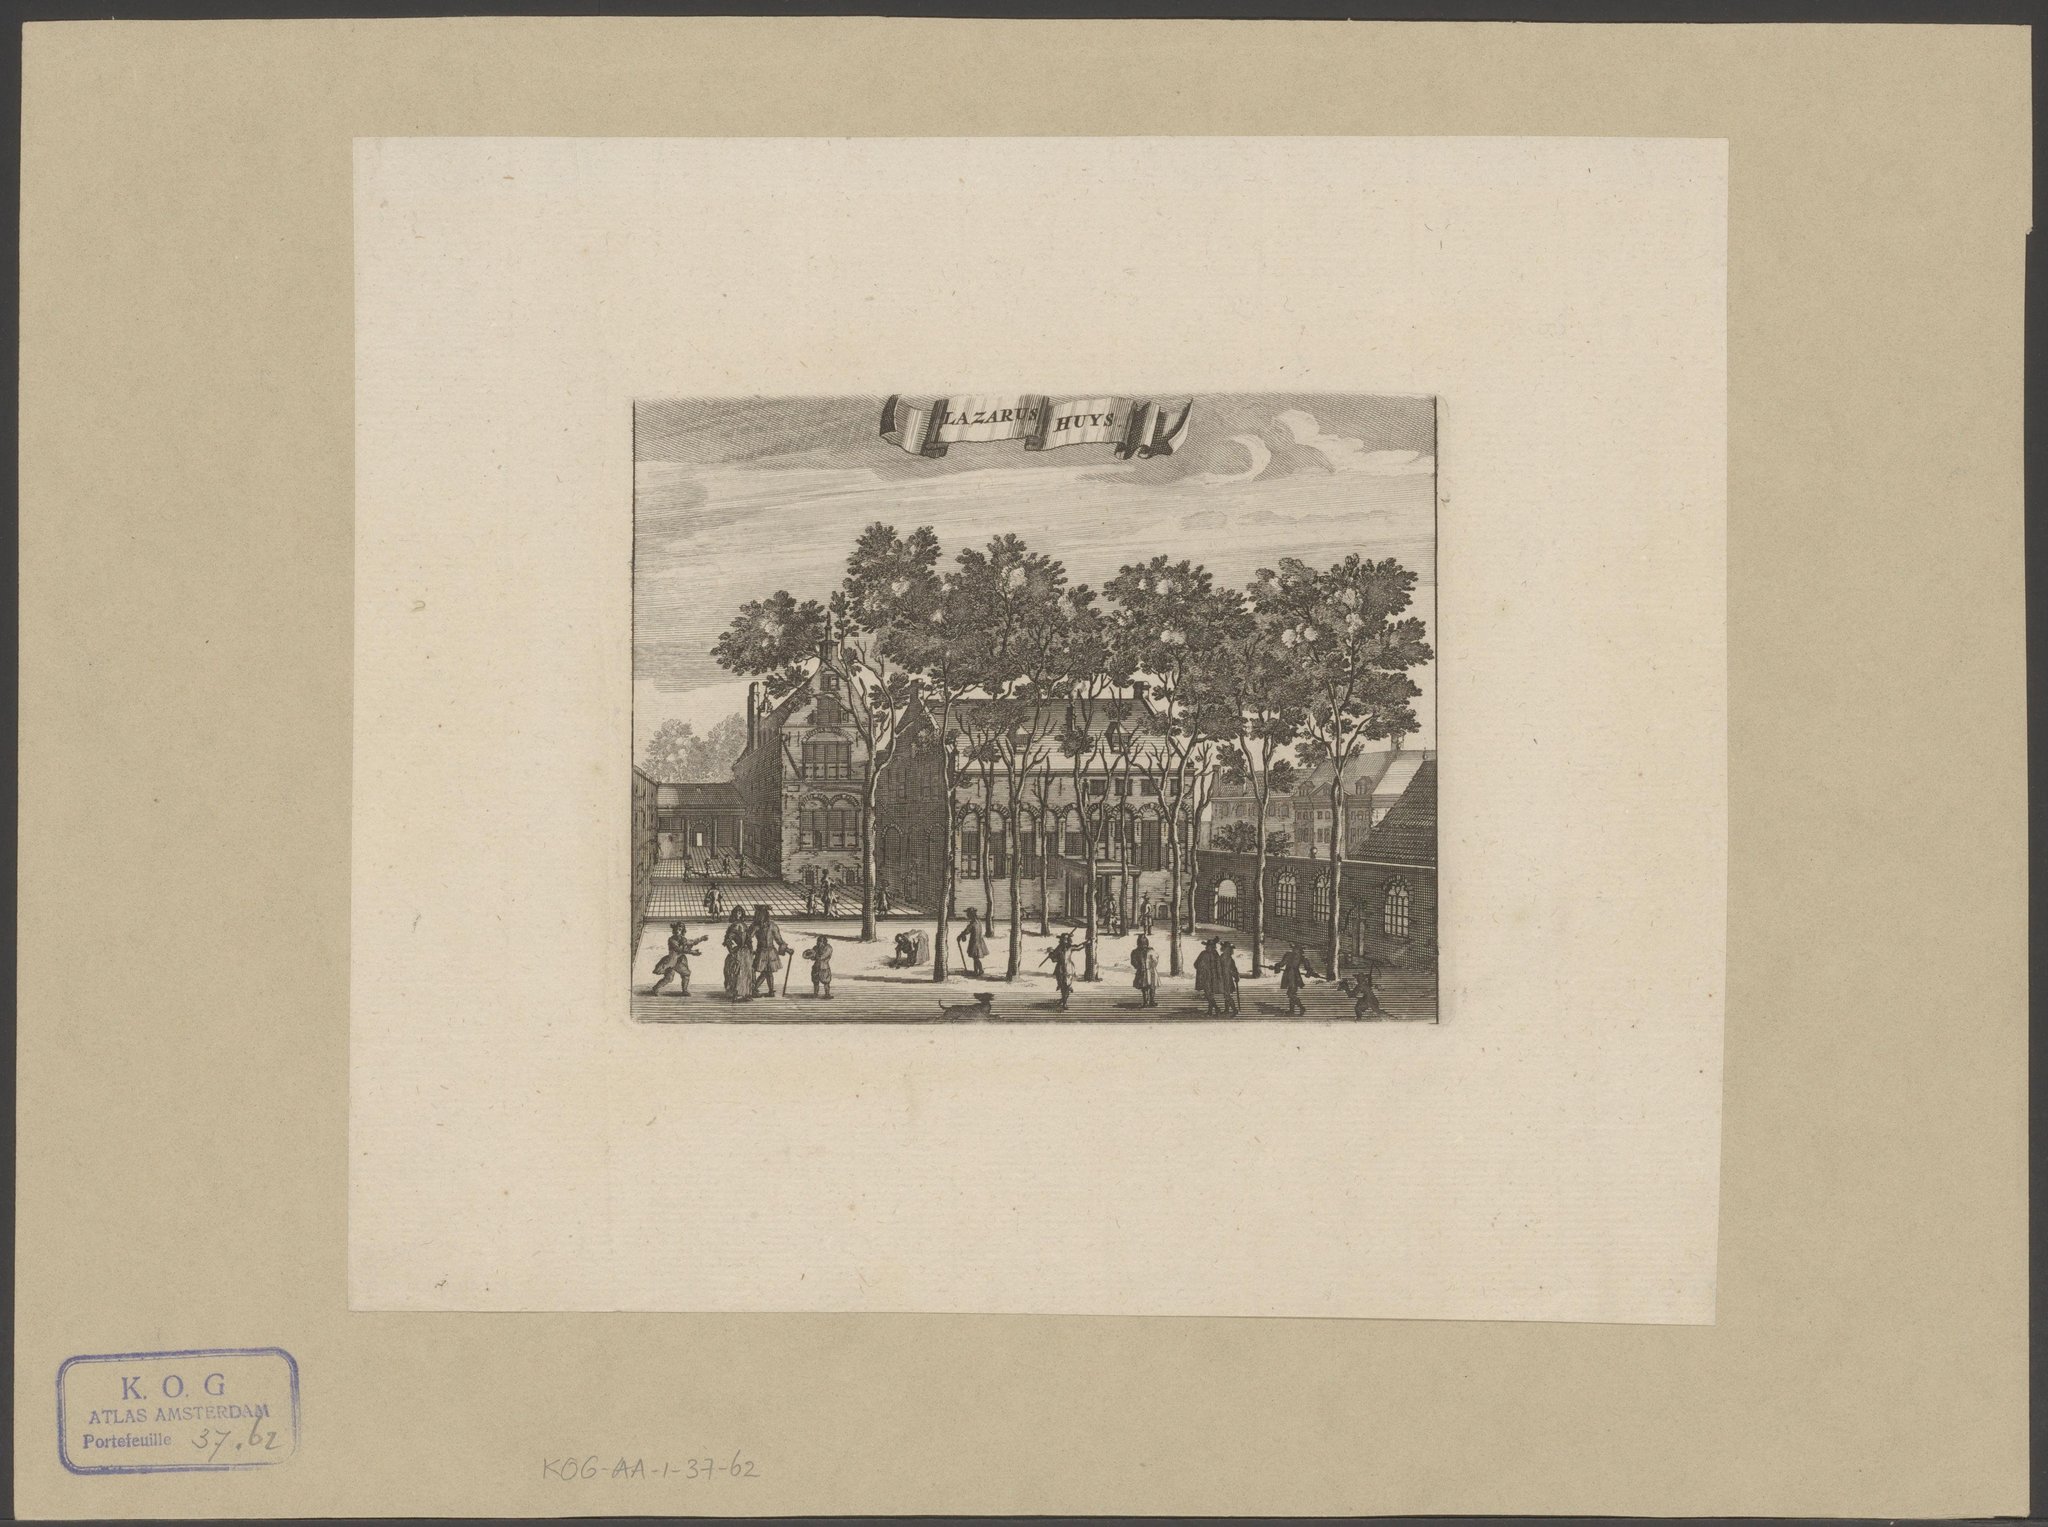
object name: print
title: Gezicht op de binnenplaats van het Leprozenhuis te Amsterdam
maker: Anonymous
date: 1726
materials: paper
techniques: engraving, etching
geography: northern netherlands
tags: leprosarium, hospital, courtyard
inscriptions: collector's mark: Lugt 1641b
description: Huidige staat van prent ook gebruikt in: Commelin, Casparus. Beschryvinge van Amsterdam (…). 2de druk. Amsterdam: Andries van Damme, Johannes Ratelband, weduwe Antony van Aeltwijk en Hermanus Uytwerf, 1726, dl. 1, p. 556. Eerste staat van prent (zonder opgewerkte lucht) ook gebruikt in: Commelin, Casparus. Beschryvinge van Amsterdam (…). Amsterdam: Abraham Wolfgang, Gillis Janssonius van Waesberge of Johannes Janssonius van Waesberge, Hendrick Boom of weduwe Dirk Boom, Abraham van Sanderen en Rembertus Goethals, 1693, dl. 1, p. 556. En in: Commelin, Casparus. Beschryvinge van Amsterdam (…). Amsterdam: weduwe Aart Dircksz. Oossaan, 1694, dl. 1, p. 556.